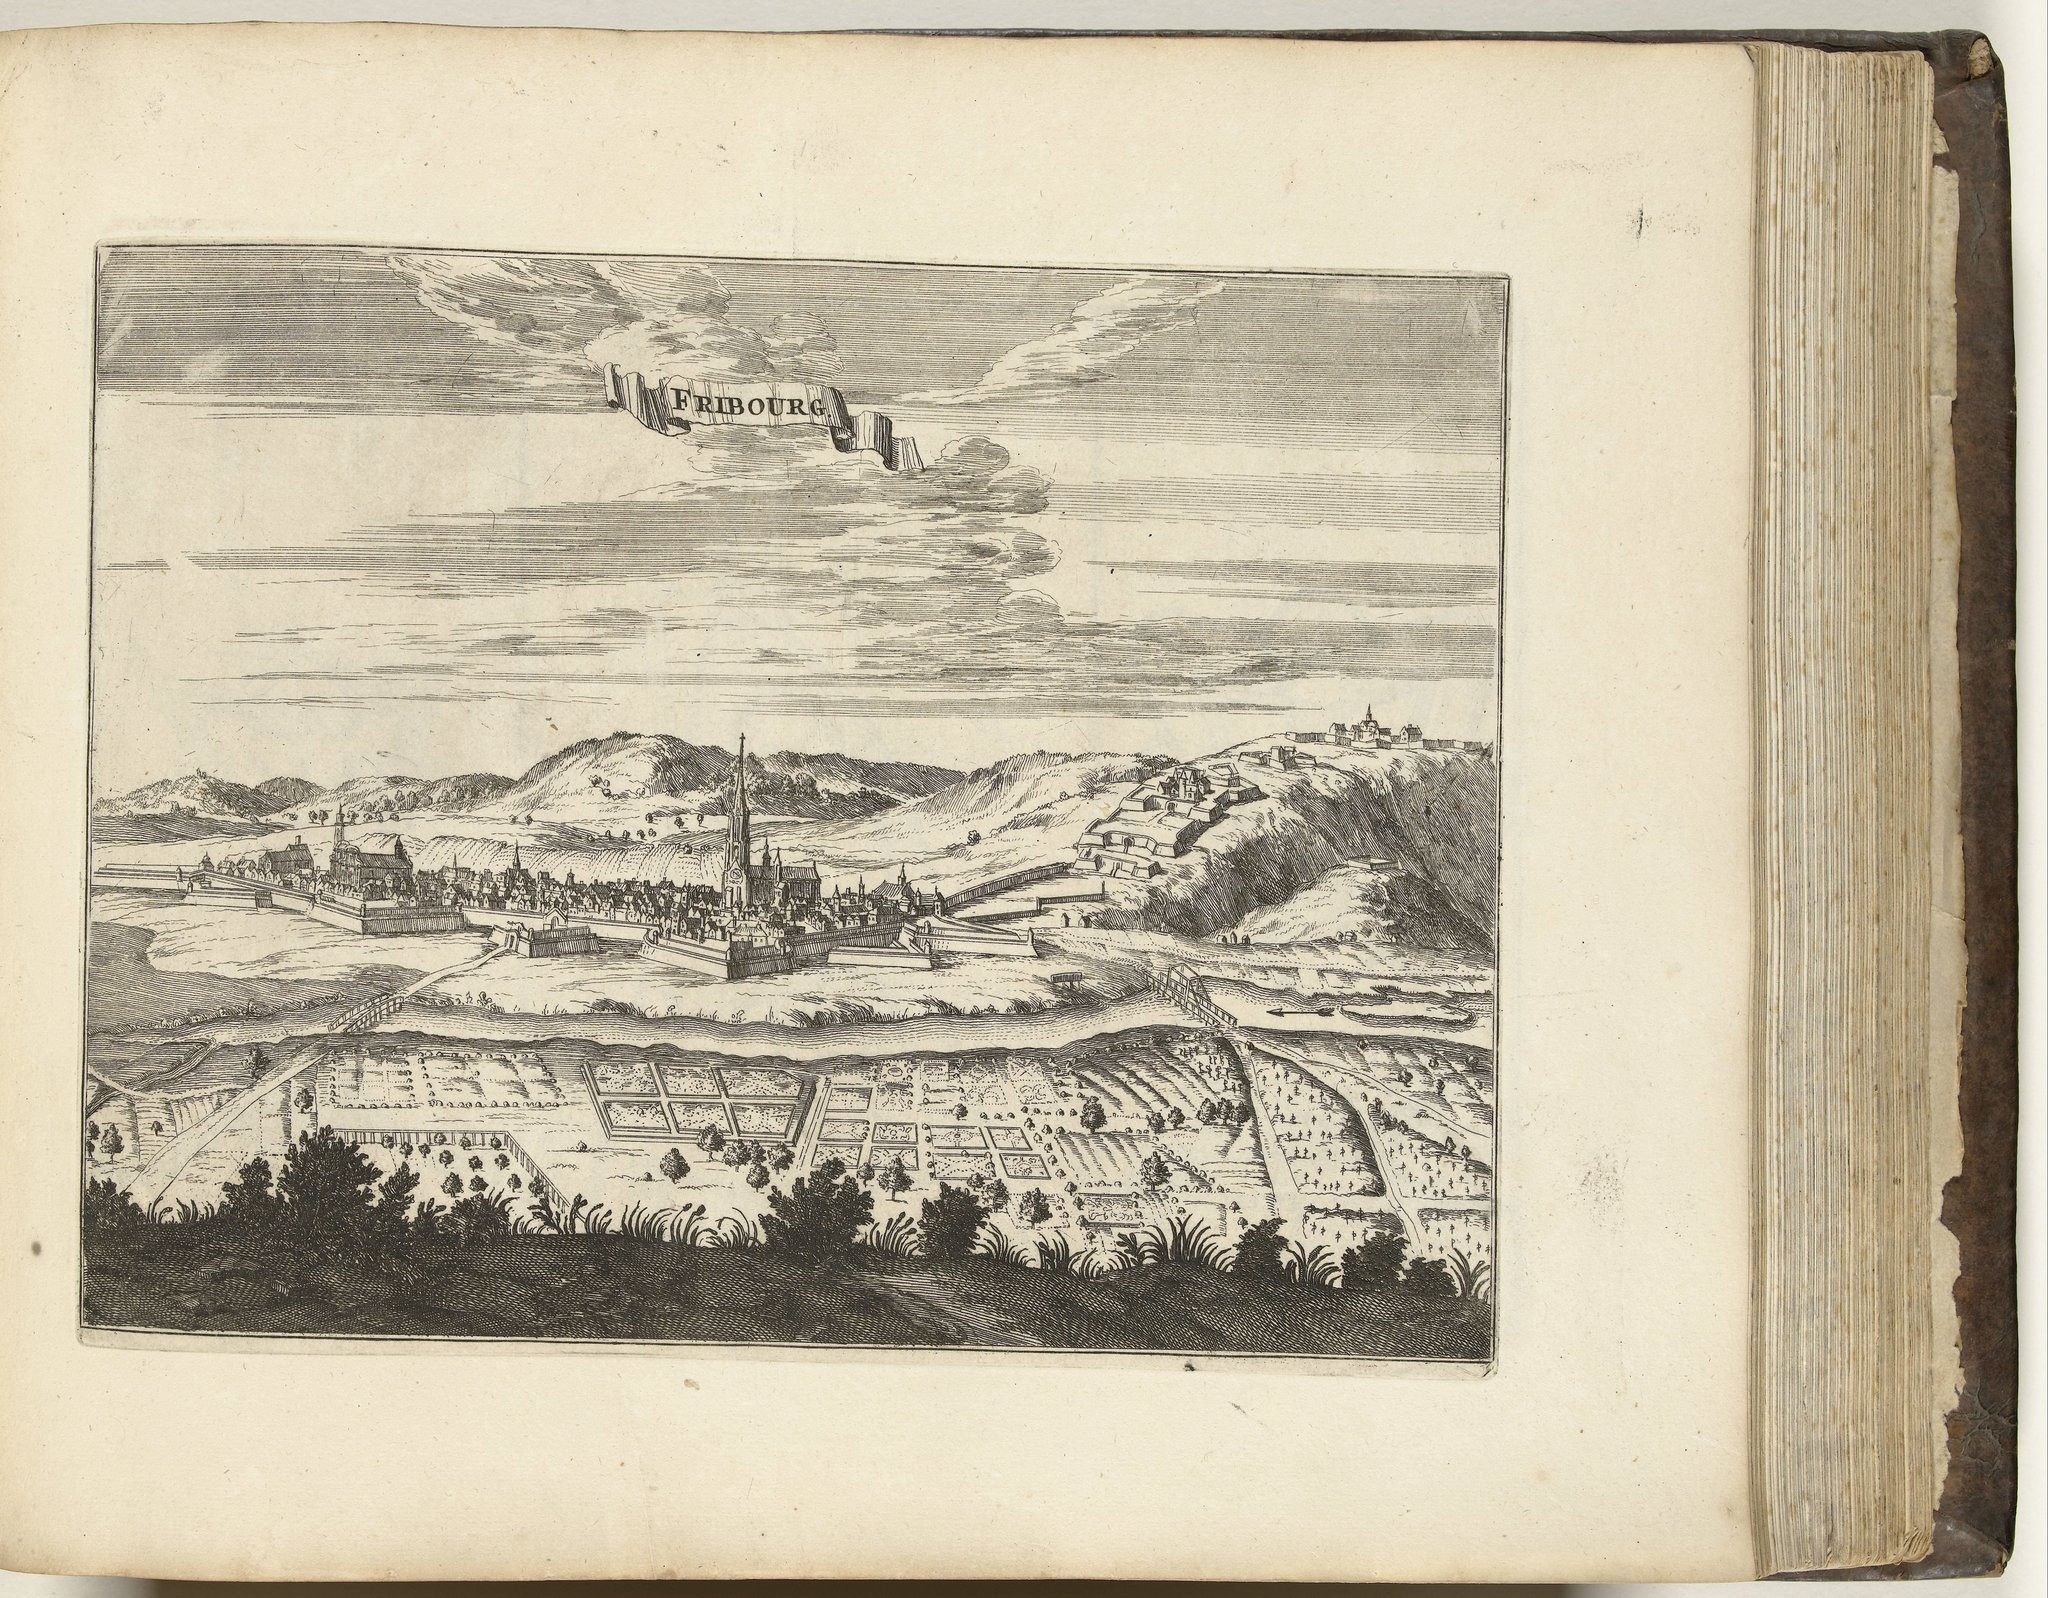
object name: print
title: Les forces de l'Europe, ou description des principales villes, avec leurs fortifications : dessignées par les meilleurs ingenieurs, particulierement celles (...) de la France, dont les plans ont esté levez par M. de Vauban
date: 1693-1696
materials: paper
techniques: etching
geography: paris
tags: fribourg, negenjarige oorlog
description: Gezicht op de Zwitserse stad Fribourg. Onderdeel van het vijfde deel (1696) van het prentwerk waarin gebundeld zijn de acht delen van Les forces de l'Europe uitgegeven tussen 1693-1697. Het prentwerk bestaat uit 175 platen met plannen (afkomstig van Sébastien Le Prestre, Seigneur de Vauban) van vermaarde sterke steden en vestingen in de Negenjarige Oorlog. Titel en opschriften in het Frans.